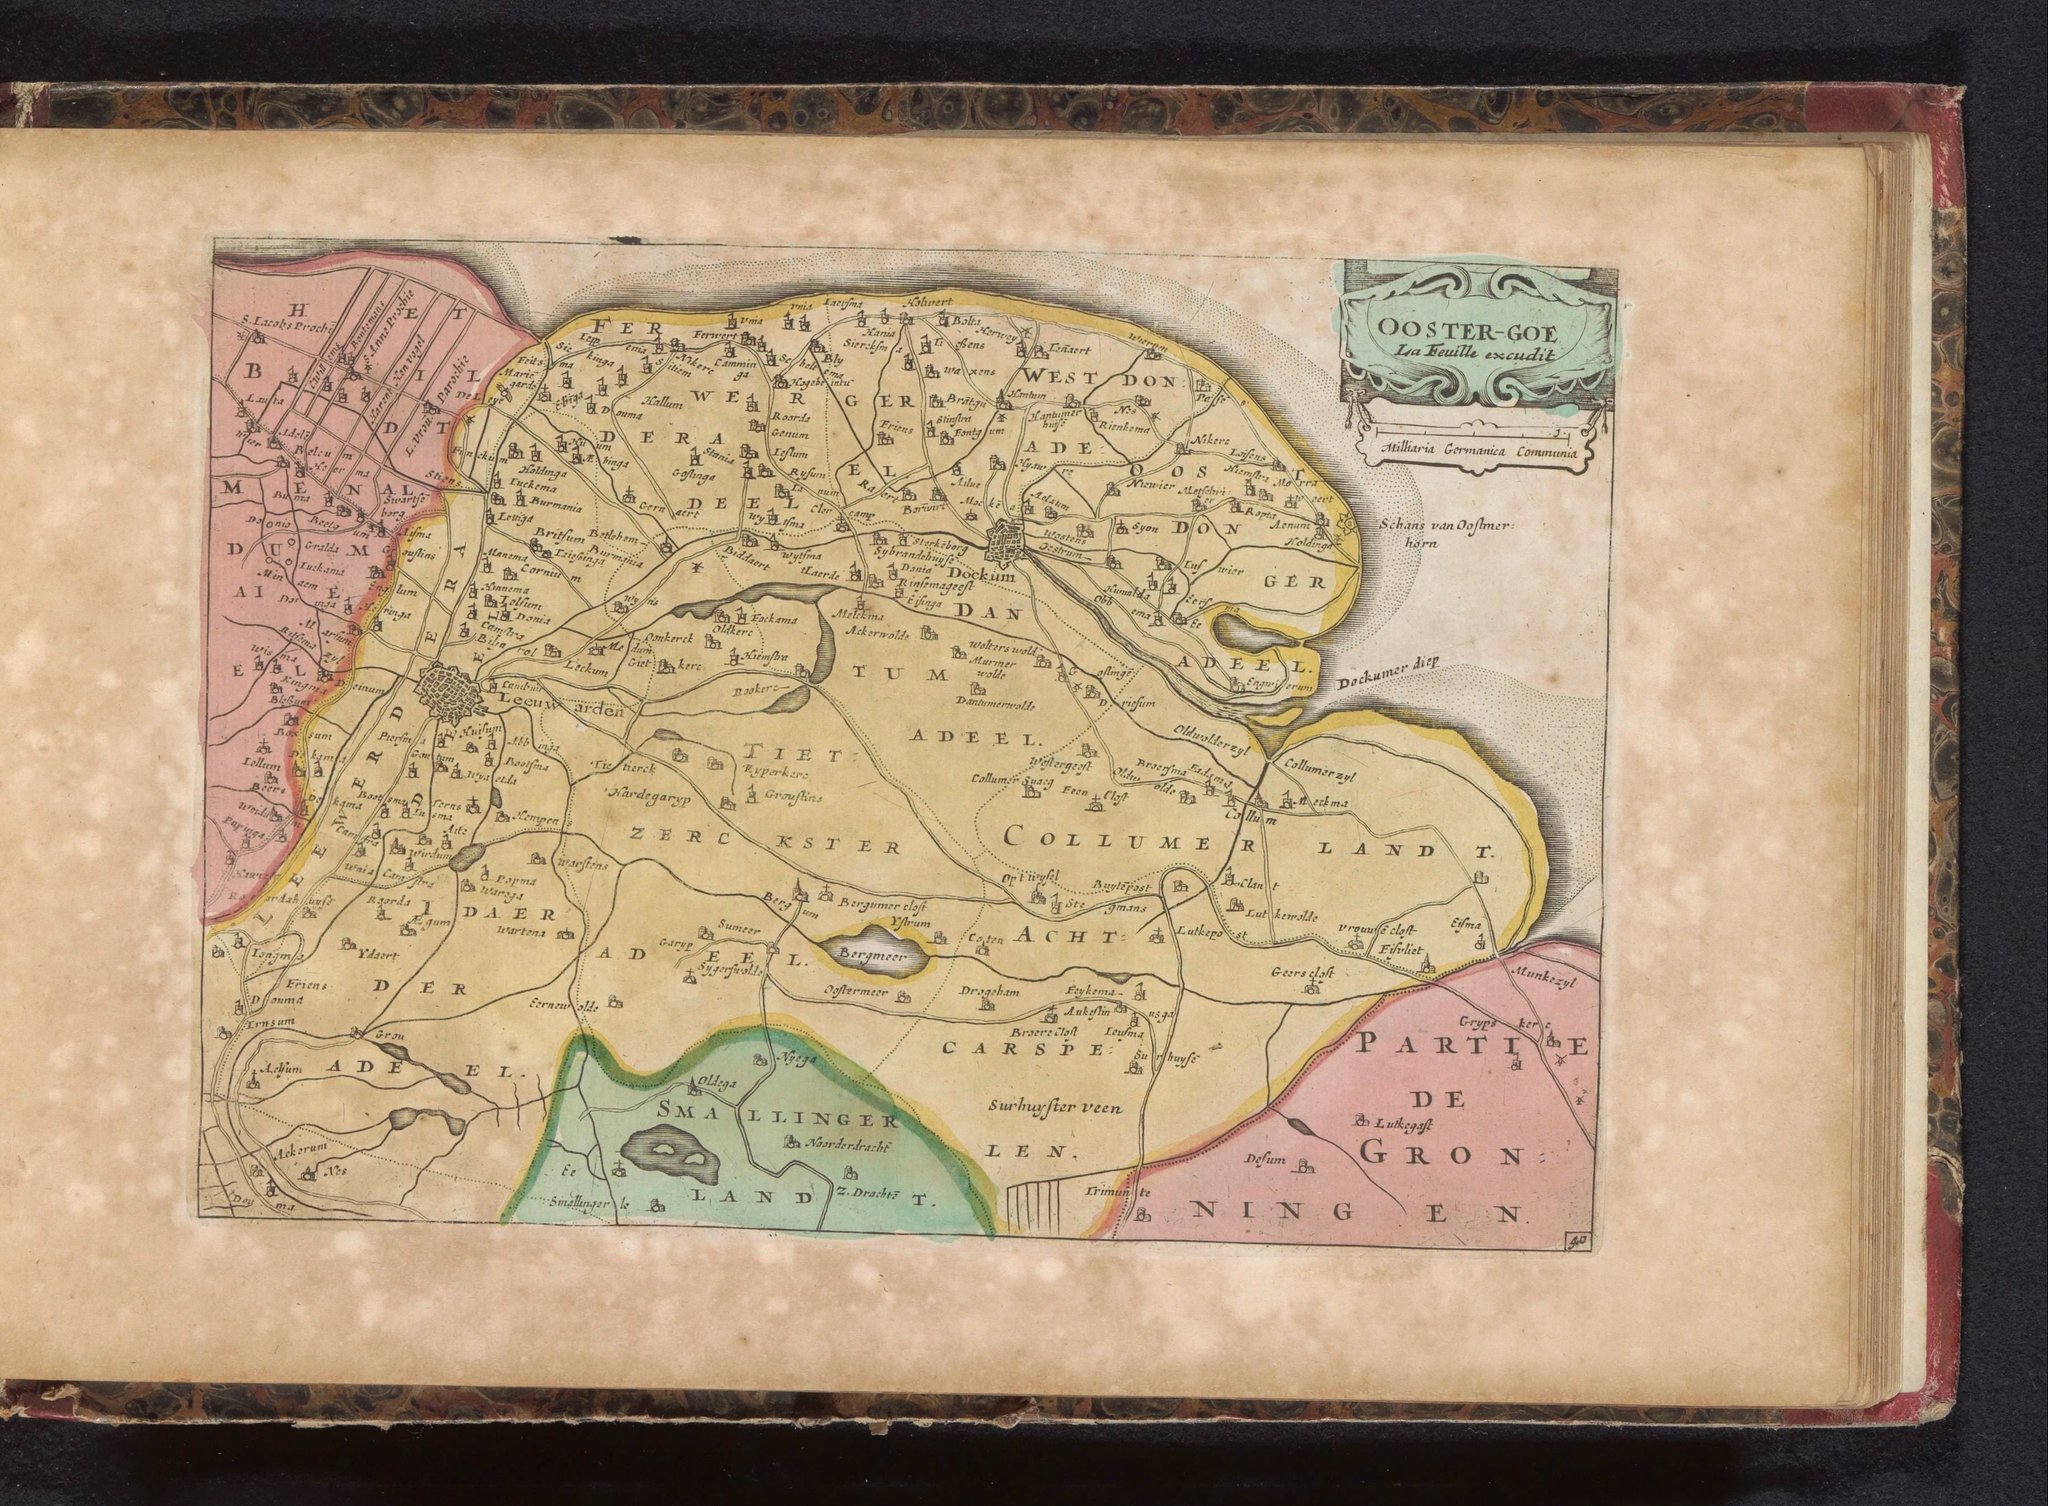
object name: print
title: Ooster-Goe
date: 1700-1702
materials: paper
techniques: engraving, hand coloring, lacquer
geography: amsterdam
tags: maps of separate countries or regions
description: Kaart van Oostergo, het oostelijke deel van Friesland. Onderdeel van een atlas met 223 kaarten van landen en steden en oorlogstaferelen in Europa in de periode ca. 1690-1735.